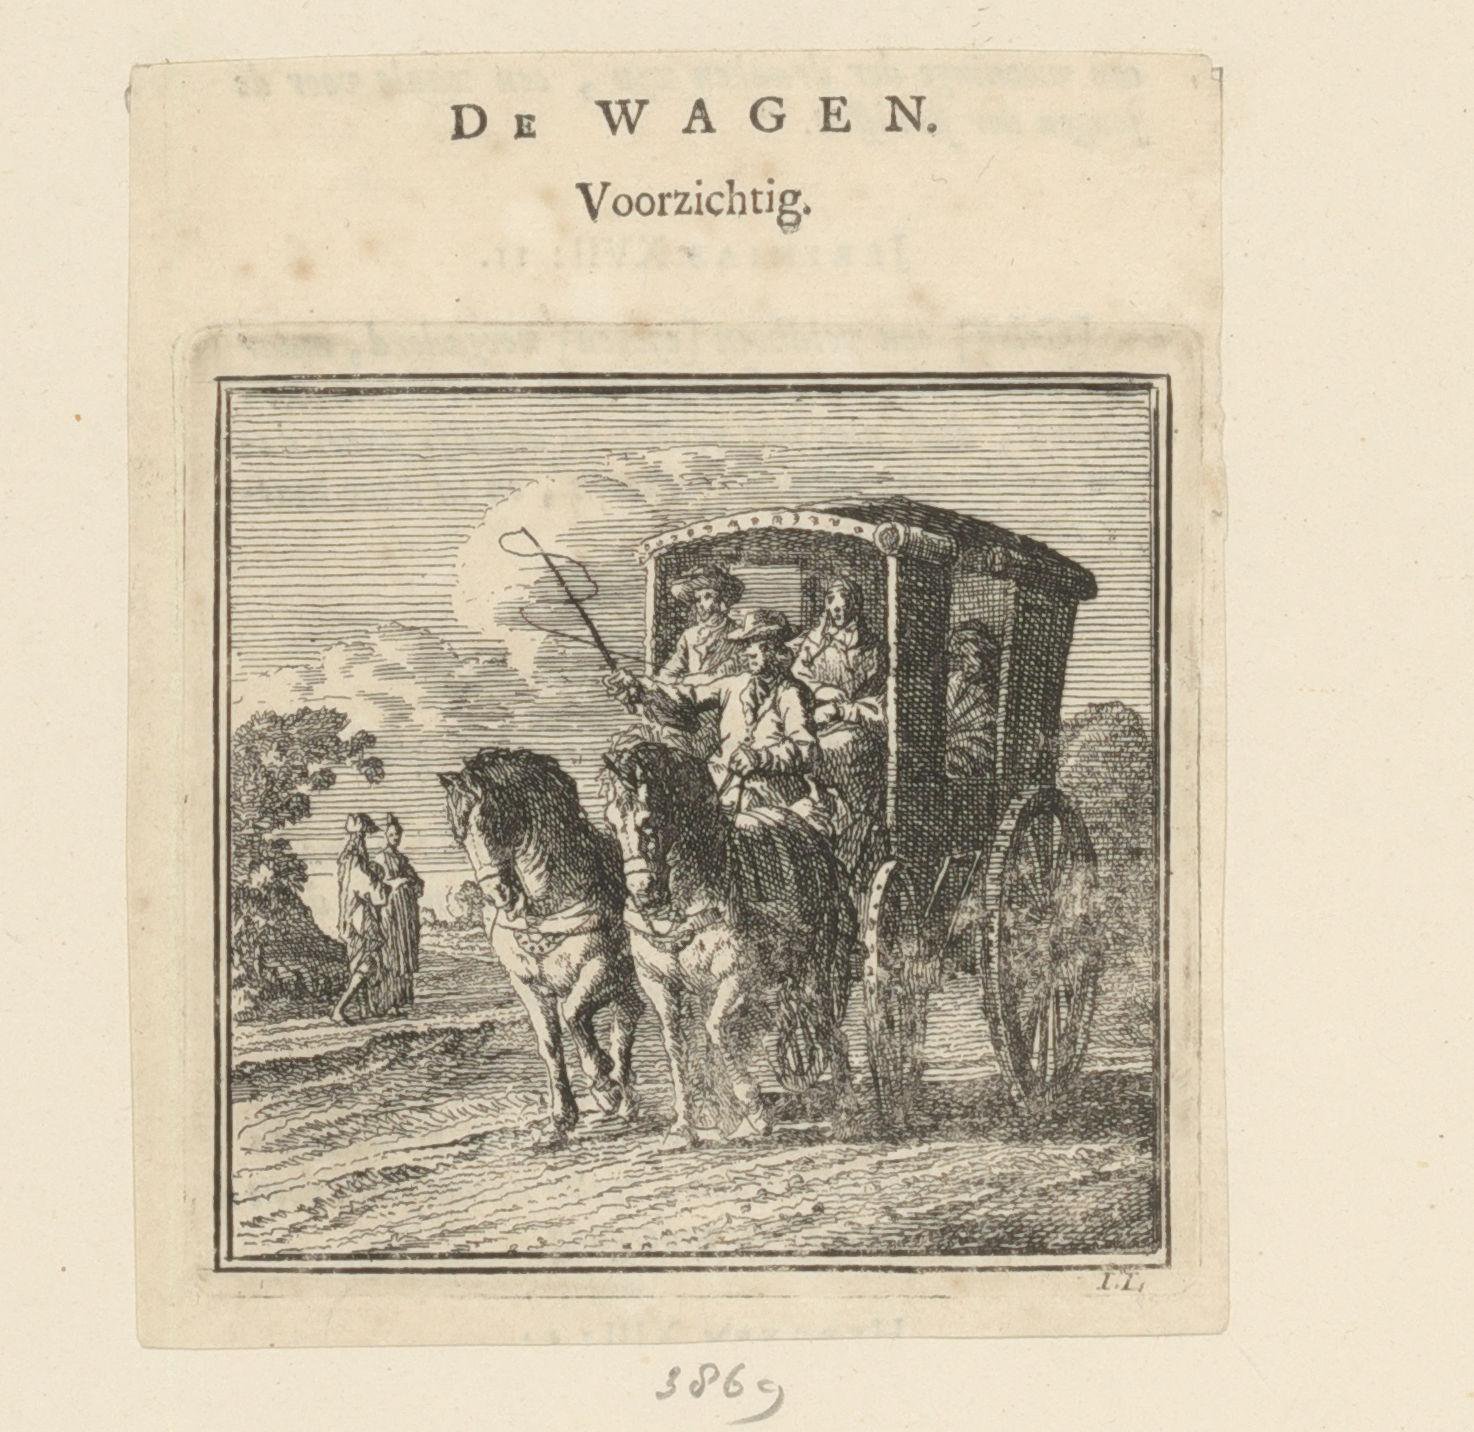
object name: print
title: De Wagen. Voorzichtig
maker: jan luyken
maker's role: draughtsman, print maker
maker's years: 1649-1712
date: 1709-1711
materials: paper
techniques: etching, letterpress printing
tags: four-wheeled vehicle drawn by two animals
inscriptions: stamp, collector's mark: Lugt 1641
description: Onderwerpsrubrieken binnen de Atlas Zeden en Gewoonten: Vervoermiddelen te land en te water, Vervoermiddelen te land, Rijtuigen en Statiekarossen.